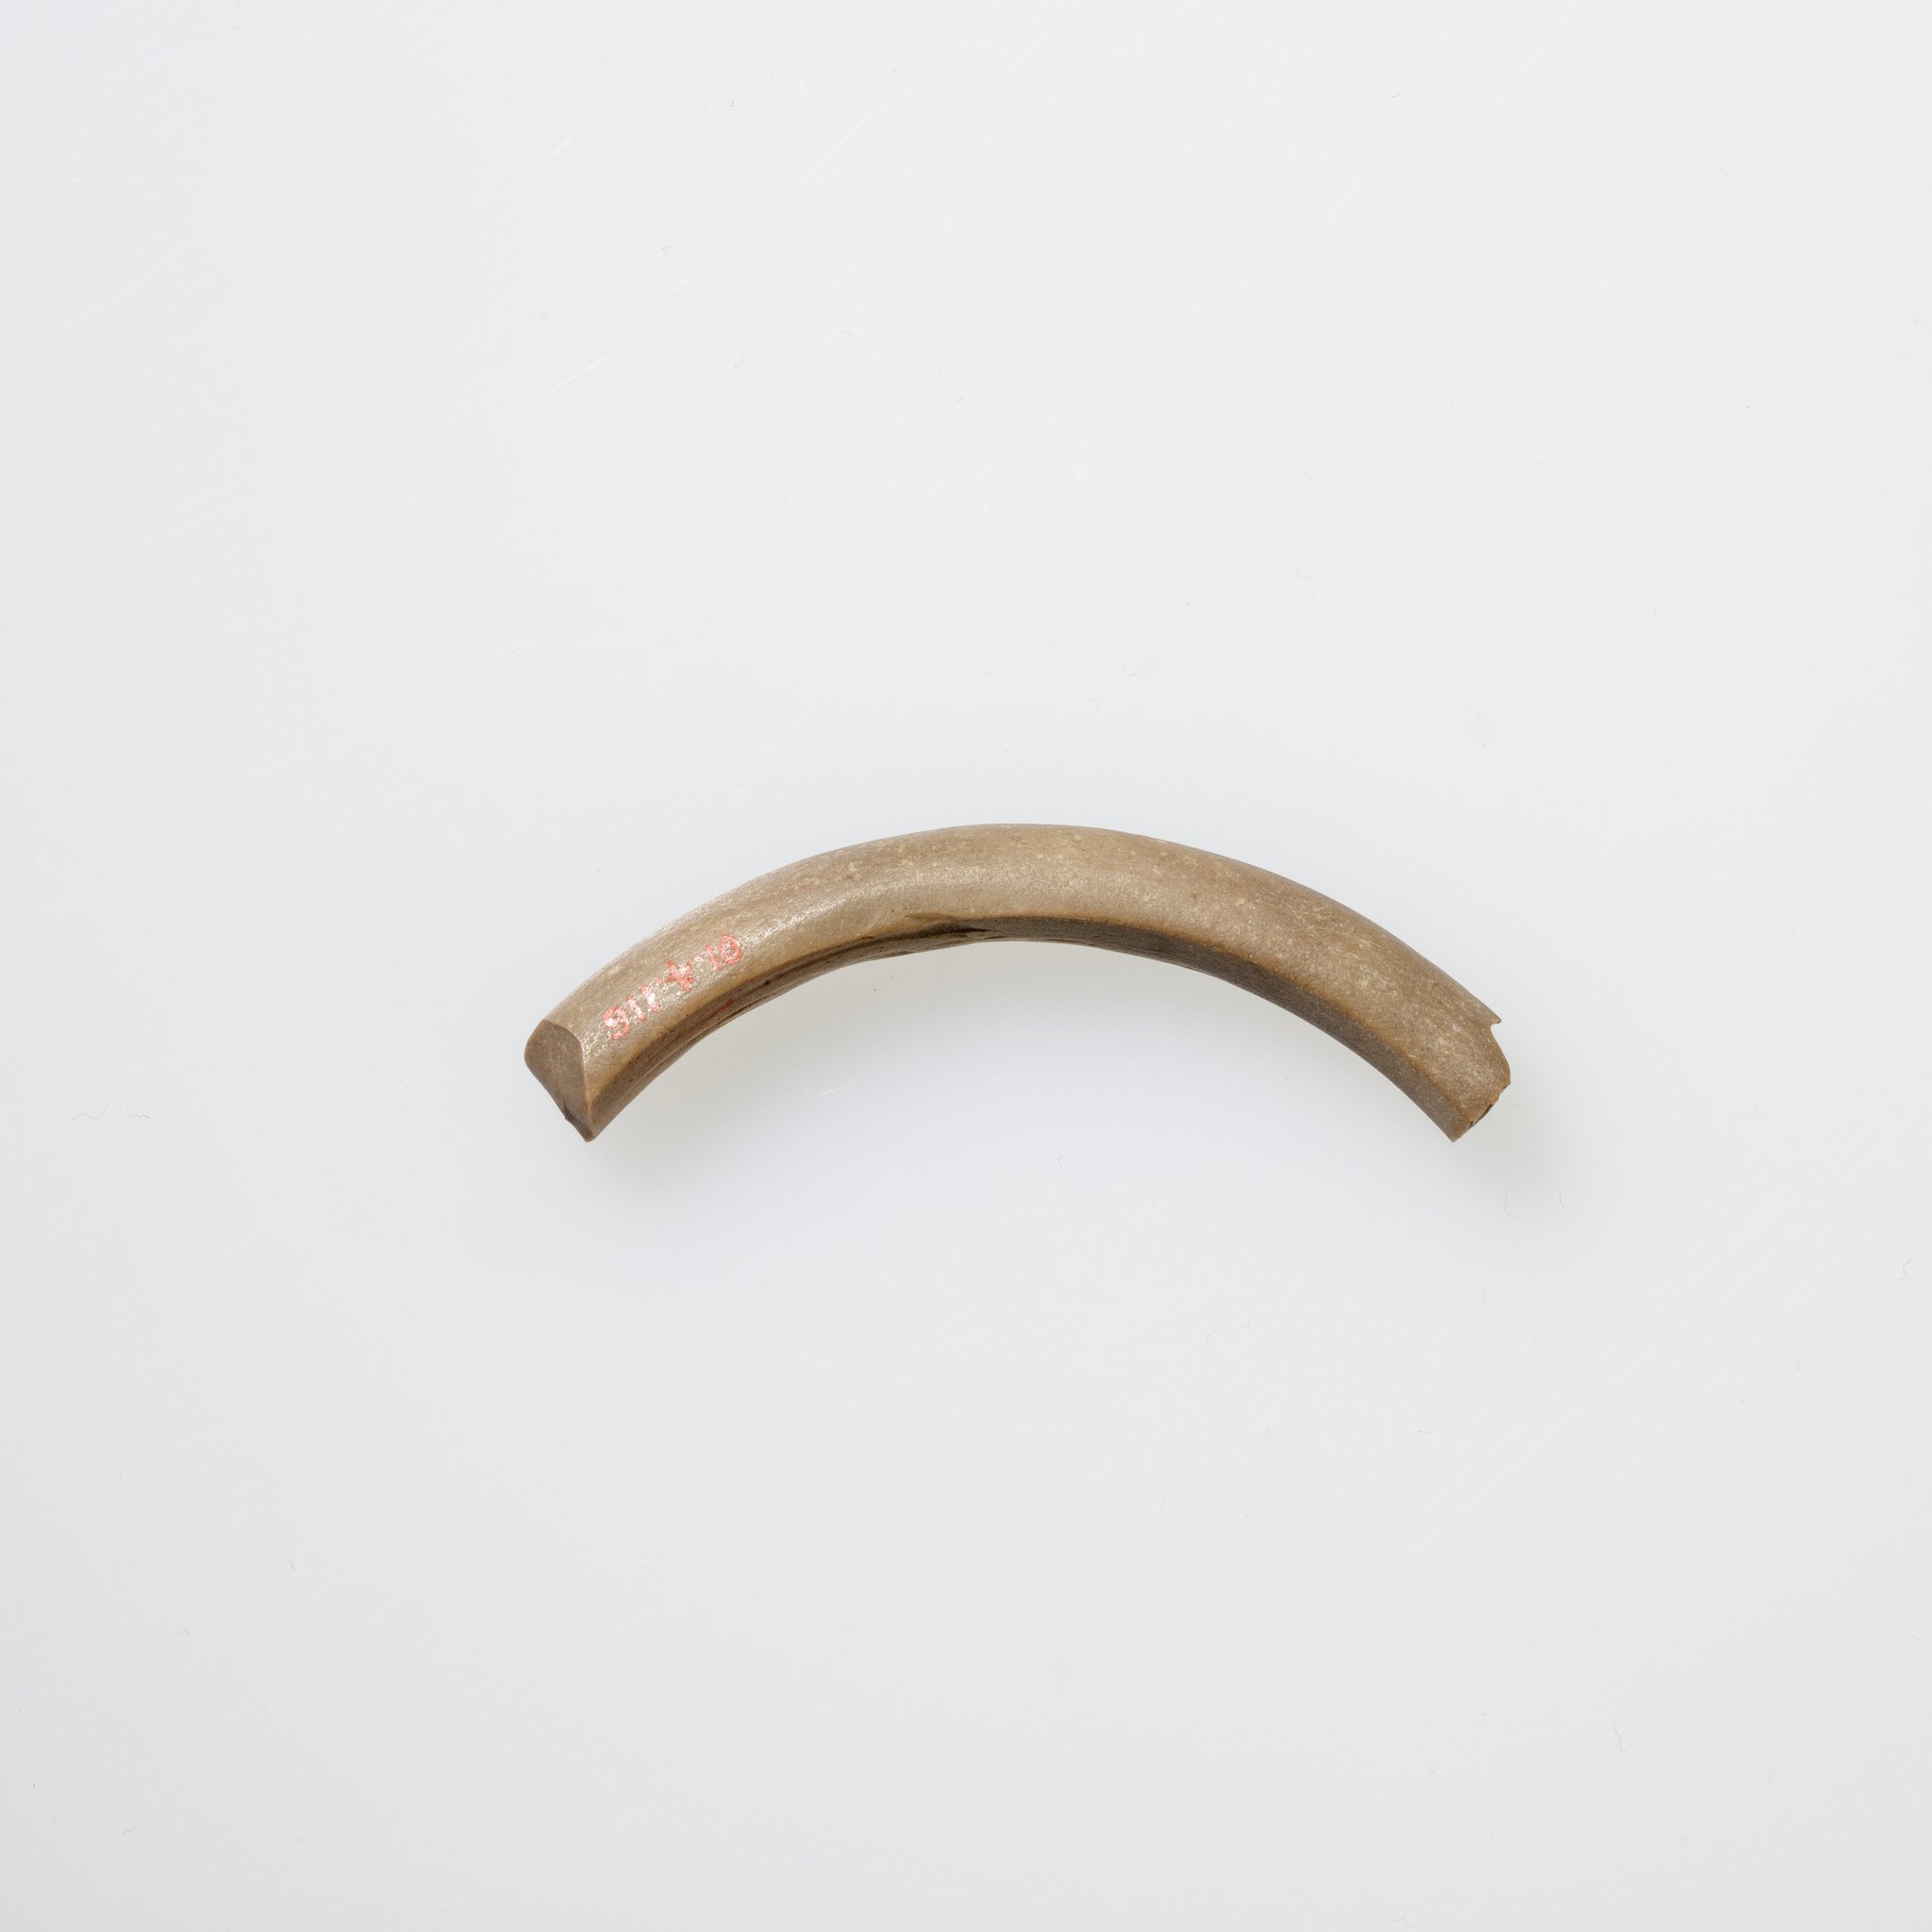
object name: bracelet, bangle, fragment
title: Bracelet (Bangle) Fragment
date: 3100-2649 BCE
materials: stone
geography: egypt